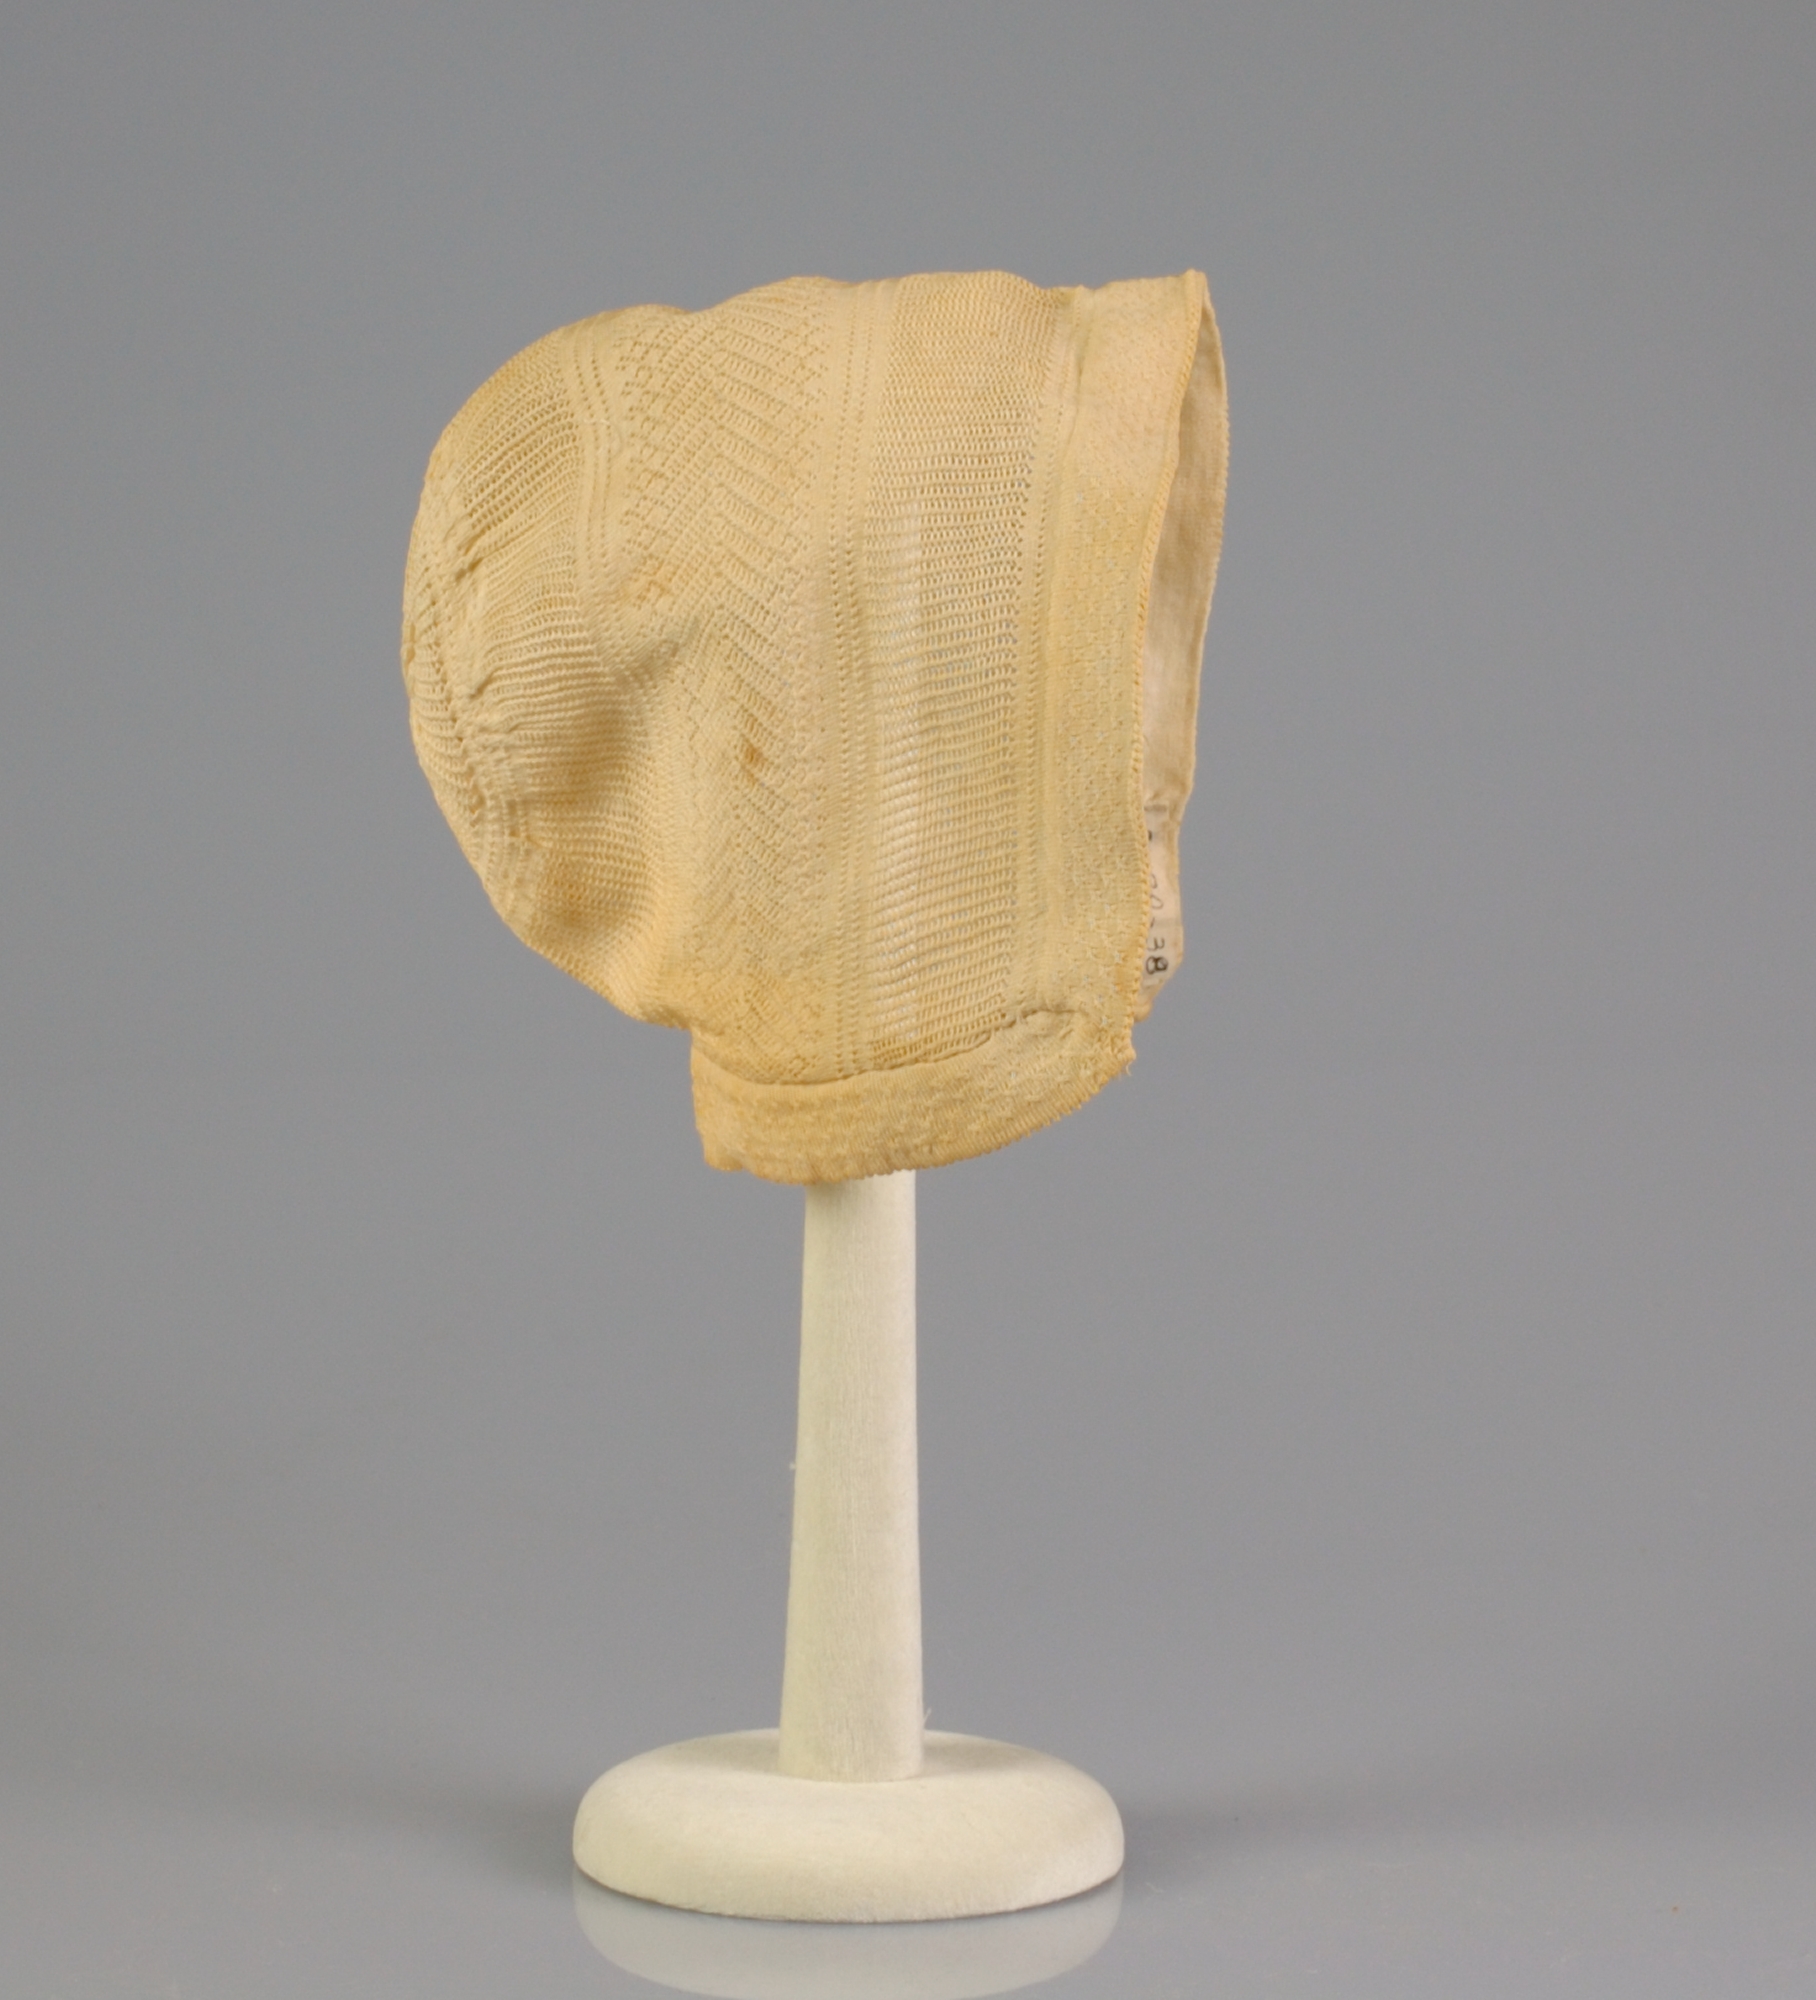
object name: cap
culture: american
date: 1850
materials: cotton